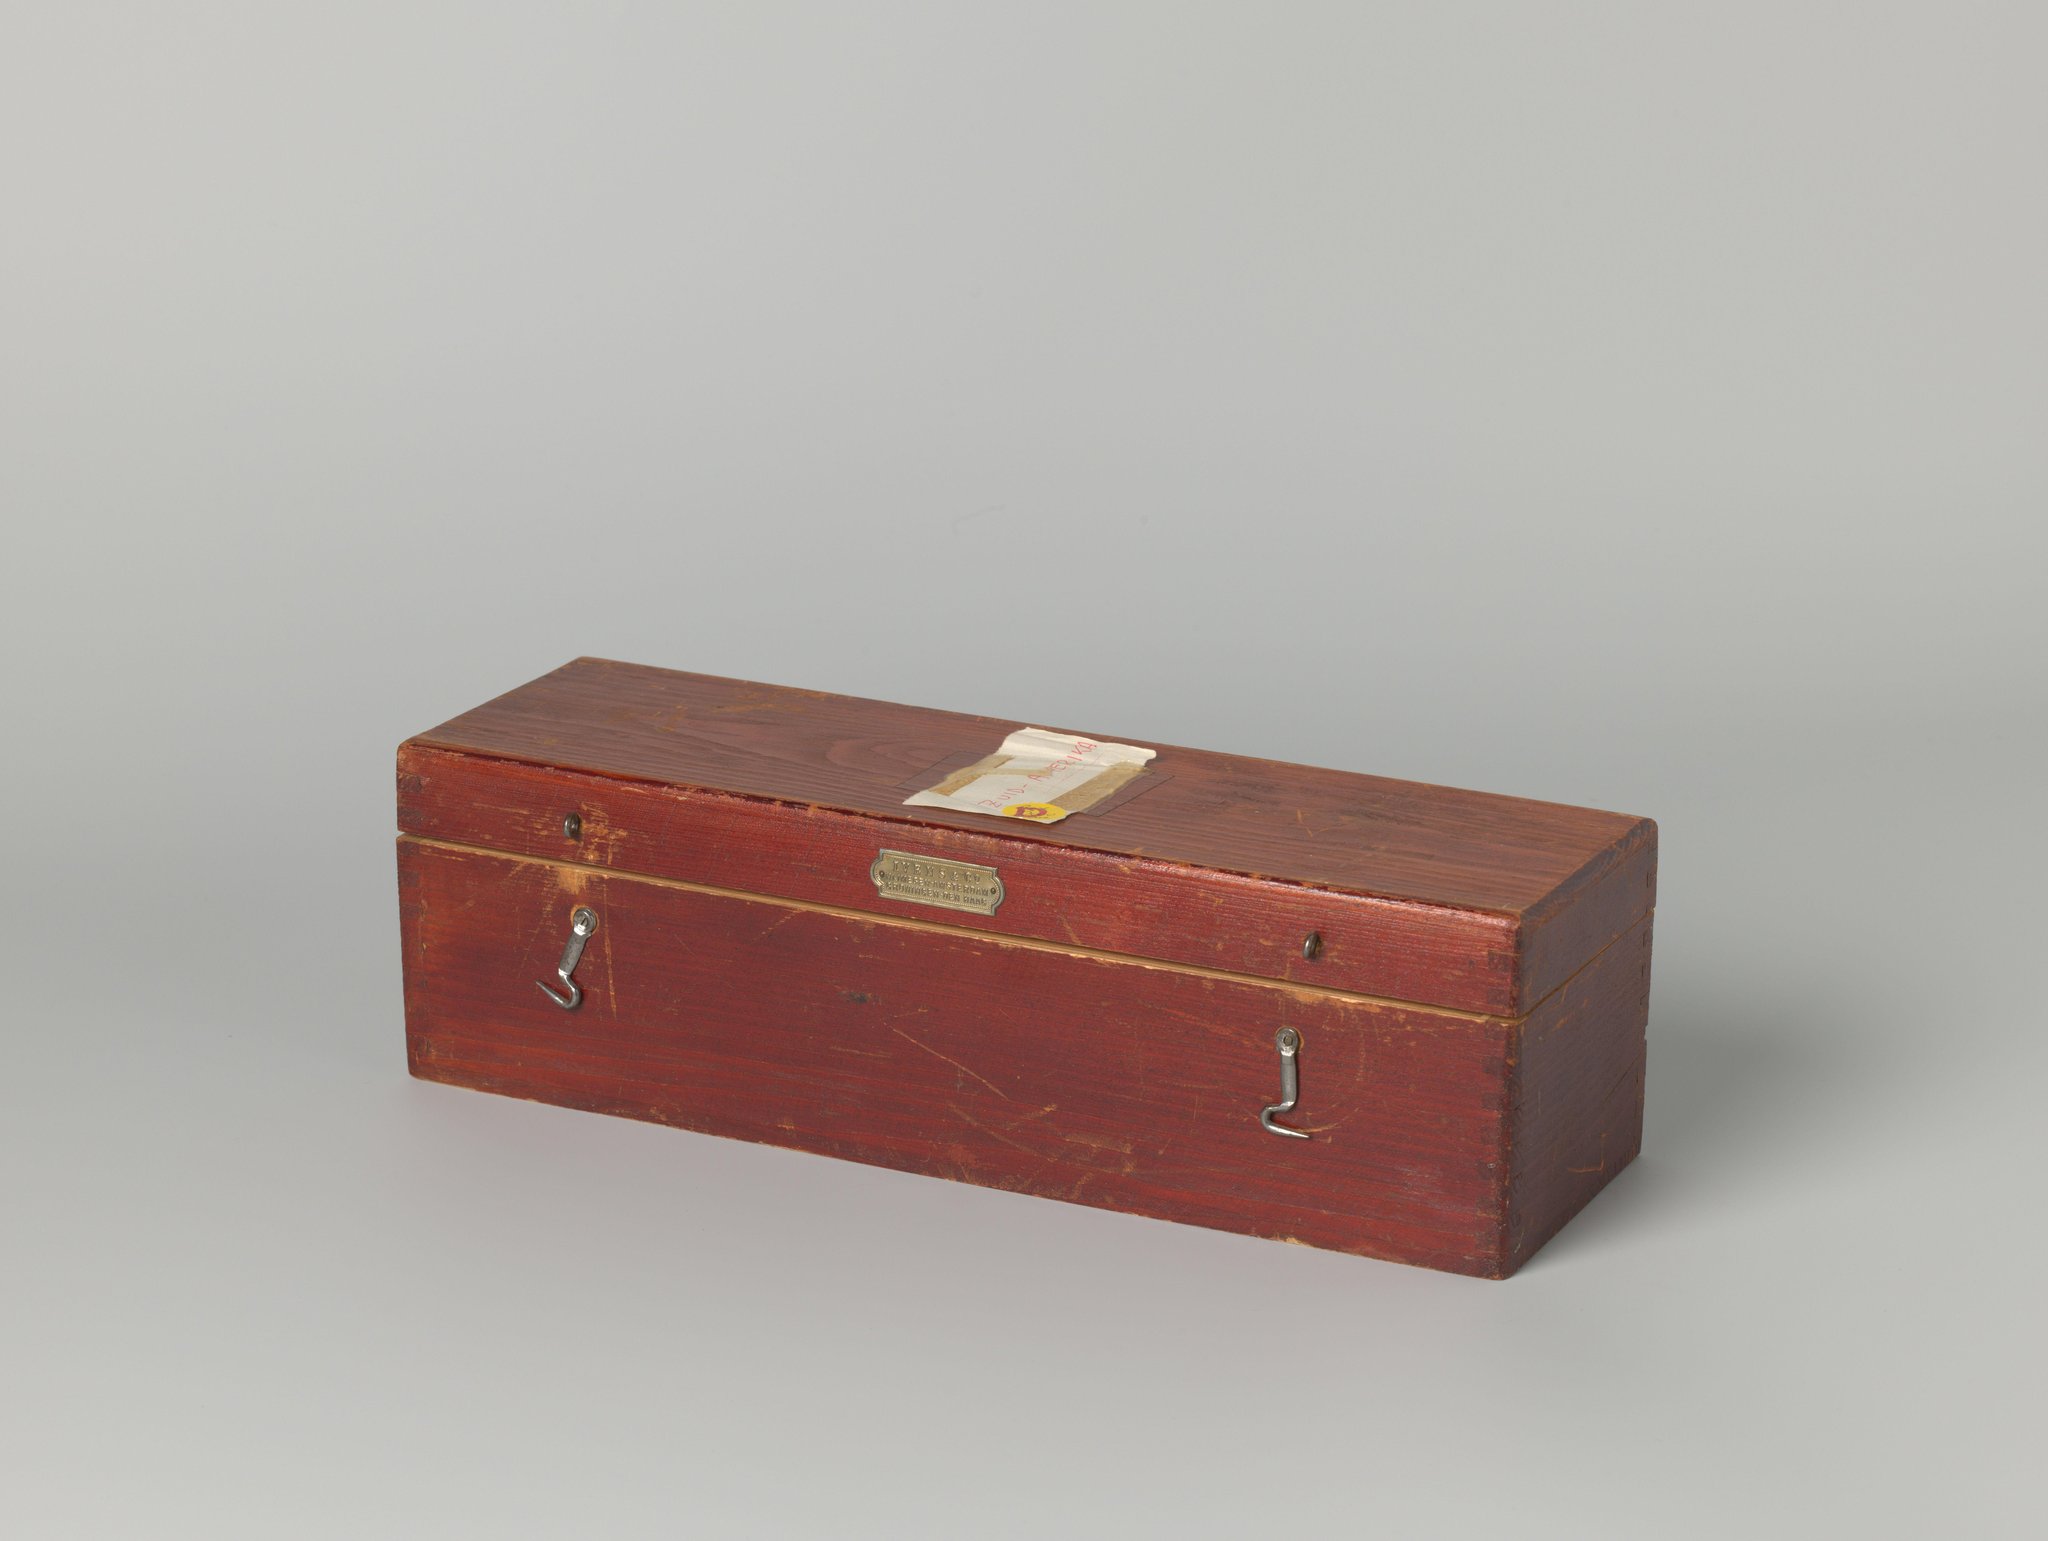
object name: chest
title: Lege houten kist voor 28 fotografische lantaarnplaatjes van de familie Kessler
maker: geldolph adriaan kessler (dolph)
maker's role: fotograaf, industrieel, voetballer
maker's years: 1884-1945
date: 1900-1910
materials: wood